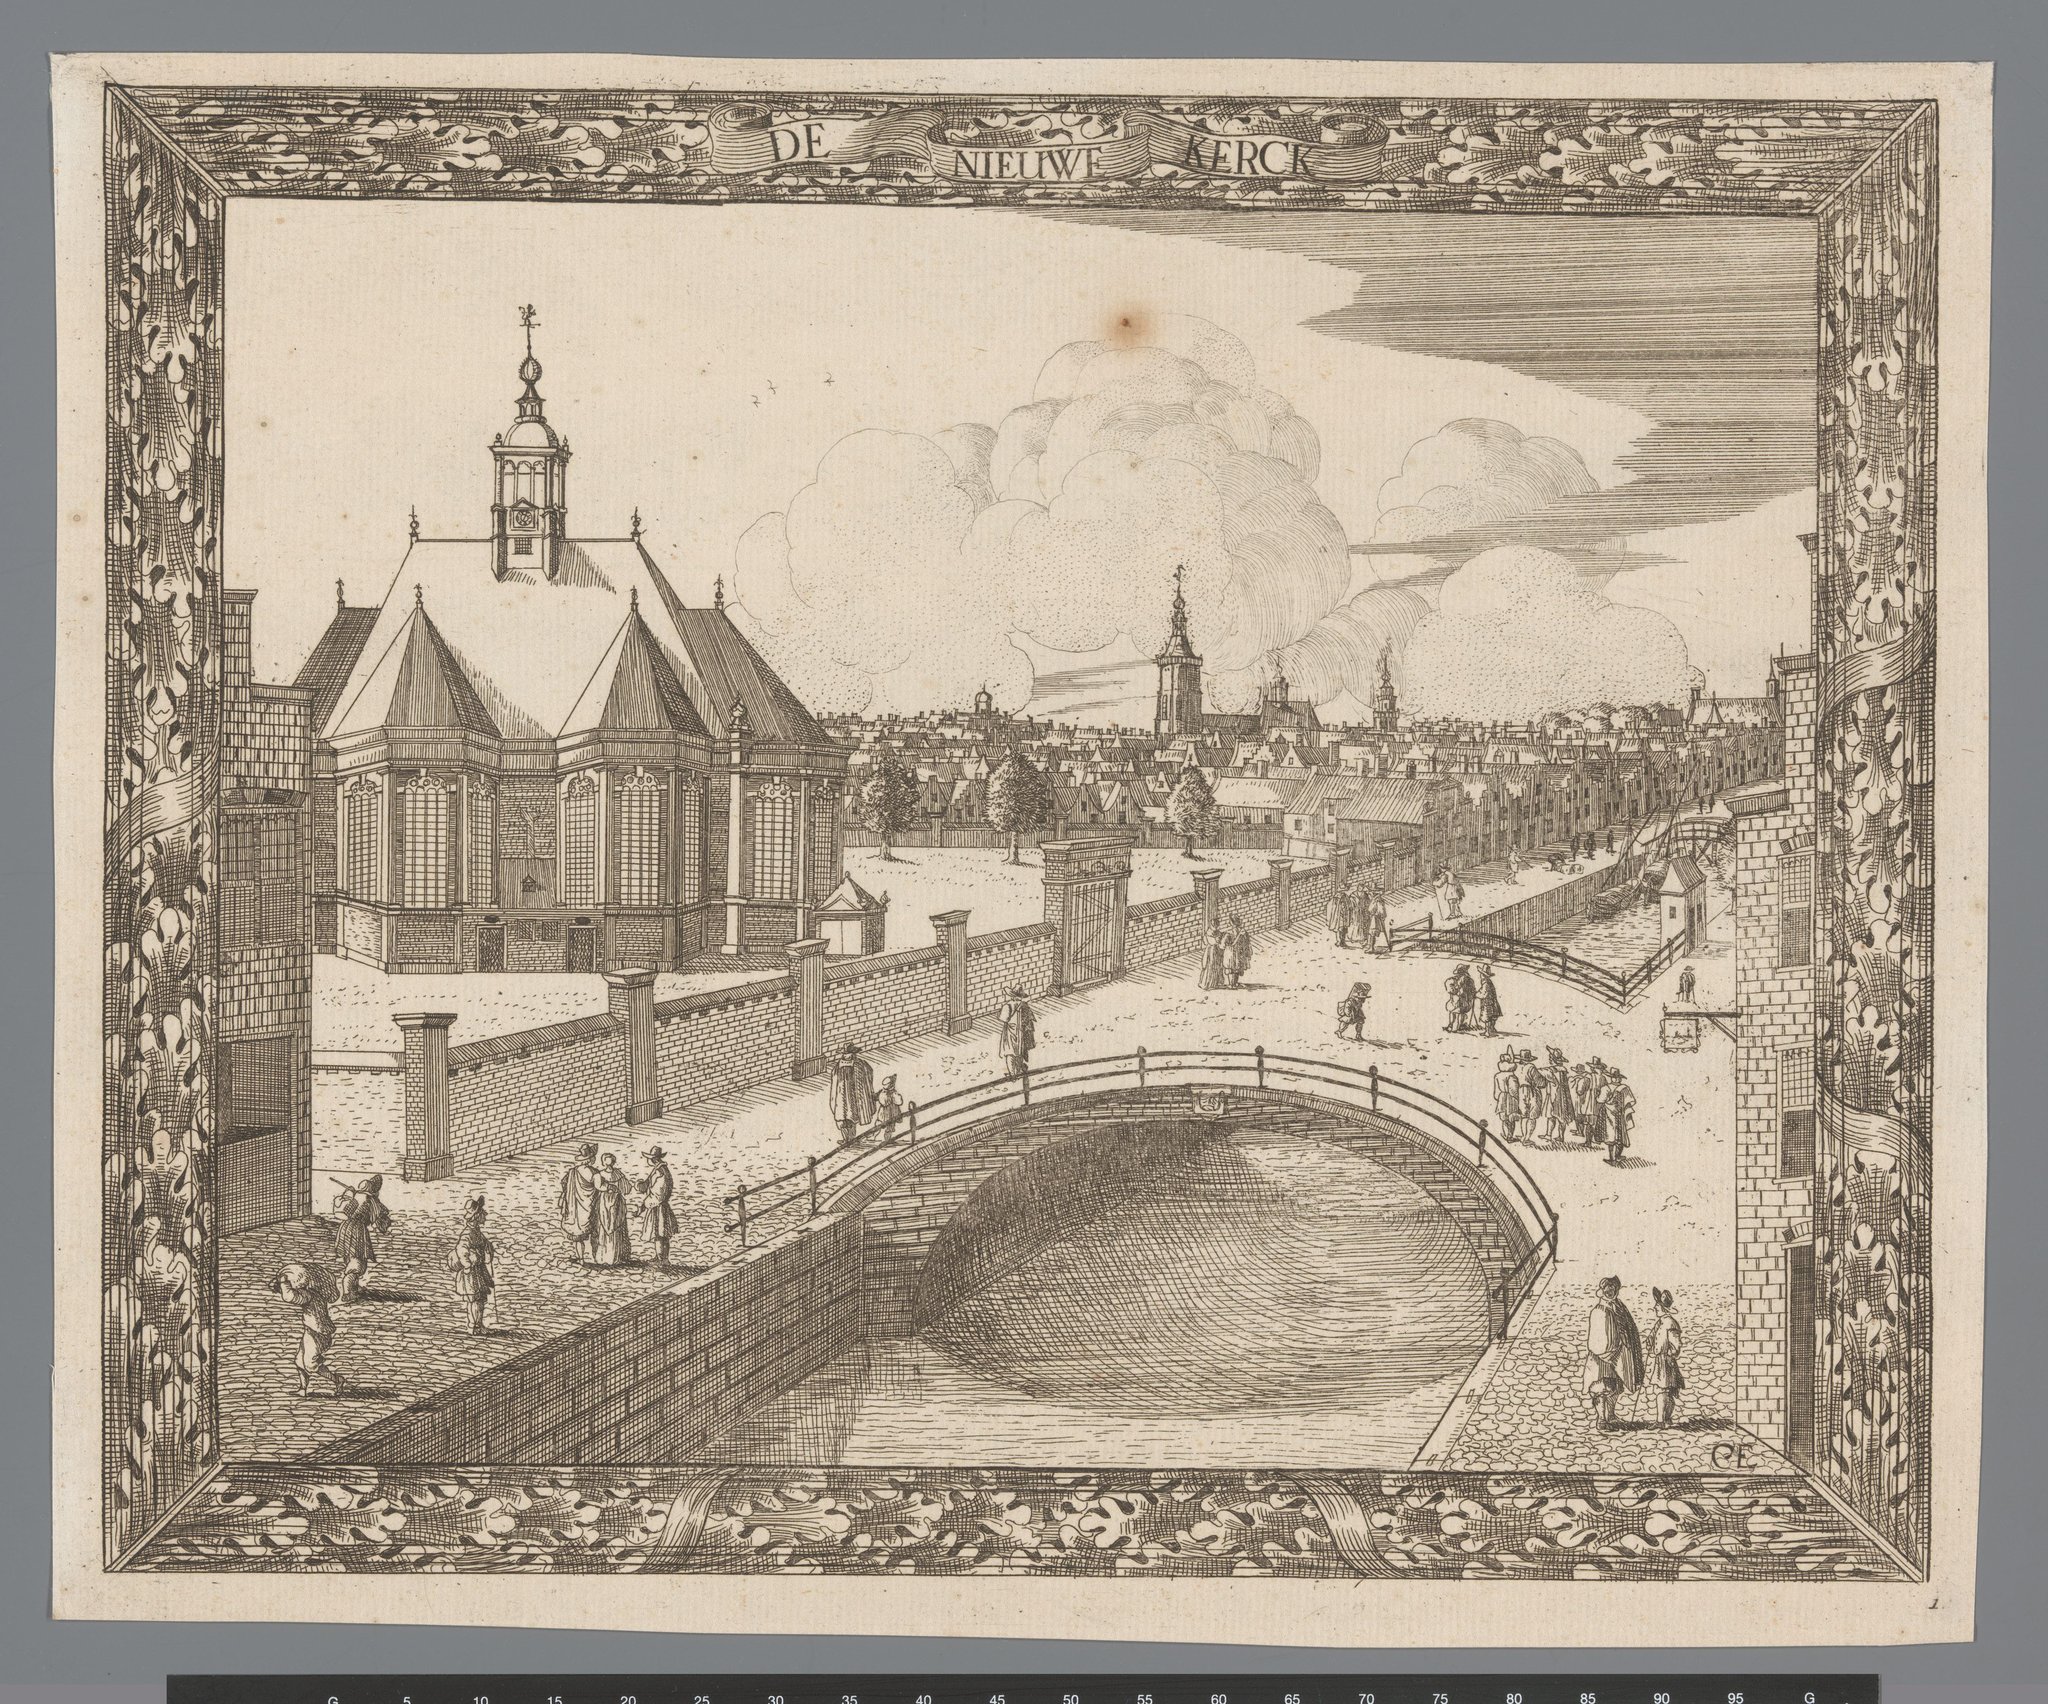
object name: print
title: De Nieuwe Kerck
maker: cornelis elandts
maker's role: draughtsman, painter, print maker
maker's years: 1641-1687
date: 1681-1728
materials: paper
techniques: etching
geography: the hague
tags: city-view, and landscape with man-made constructions, the place of worship and its equipment ~ christian churches, bridge in city across river, canal, etc., the hague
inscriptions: collector's mark: Lugt 2228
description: Deze prent is oorspronkelijk uitgegeven als onderdeel van de rand van de zogenaamde figuratieve kaart van Den Haag uit 1681-1682 (zie RP-P-AO-12-9D). De rand bestond uit een gezicht op de stad en veertien kleinere gezichten in en om Den Haag. Veertien van de vijftien prenten van de rand zijn later ook gebruikt in: Aa, Pieter van der. La galerie agreable du monde (...). 66 dln. Leiden: Pieter van der Aa, 1728, dl. 18 en 19. De huidige prent komt als enige niet voor in deze publicatie. Voor de overige prenten van de rand, zie: RP-P-AO-12-8, RP-P-AO-12-8-2, RP-P-OB-50.201, RP-P-OB-50.202, RP-P-OB-50.203, RP-P-OB-50.204, RP-P-OB-50.205, RP-P-OB-50.206, RP-P-OB-50.207, RP-P-OB-50.208, RP-P-OB-102.387, RP-P-OB-50.209, RP-P-OB-50.210, RP-P-OB-50.211, RP-P-OB-50.213, RP-P-AO-12-5-4 en RP-P-OB-50.214.